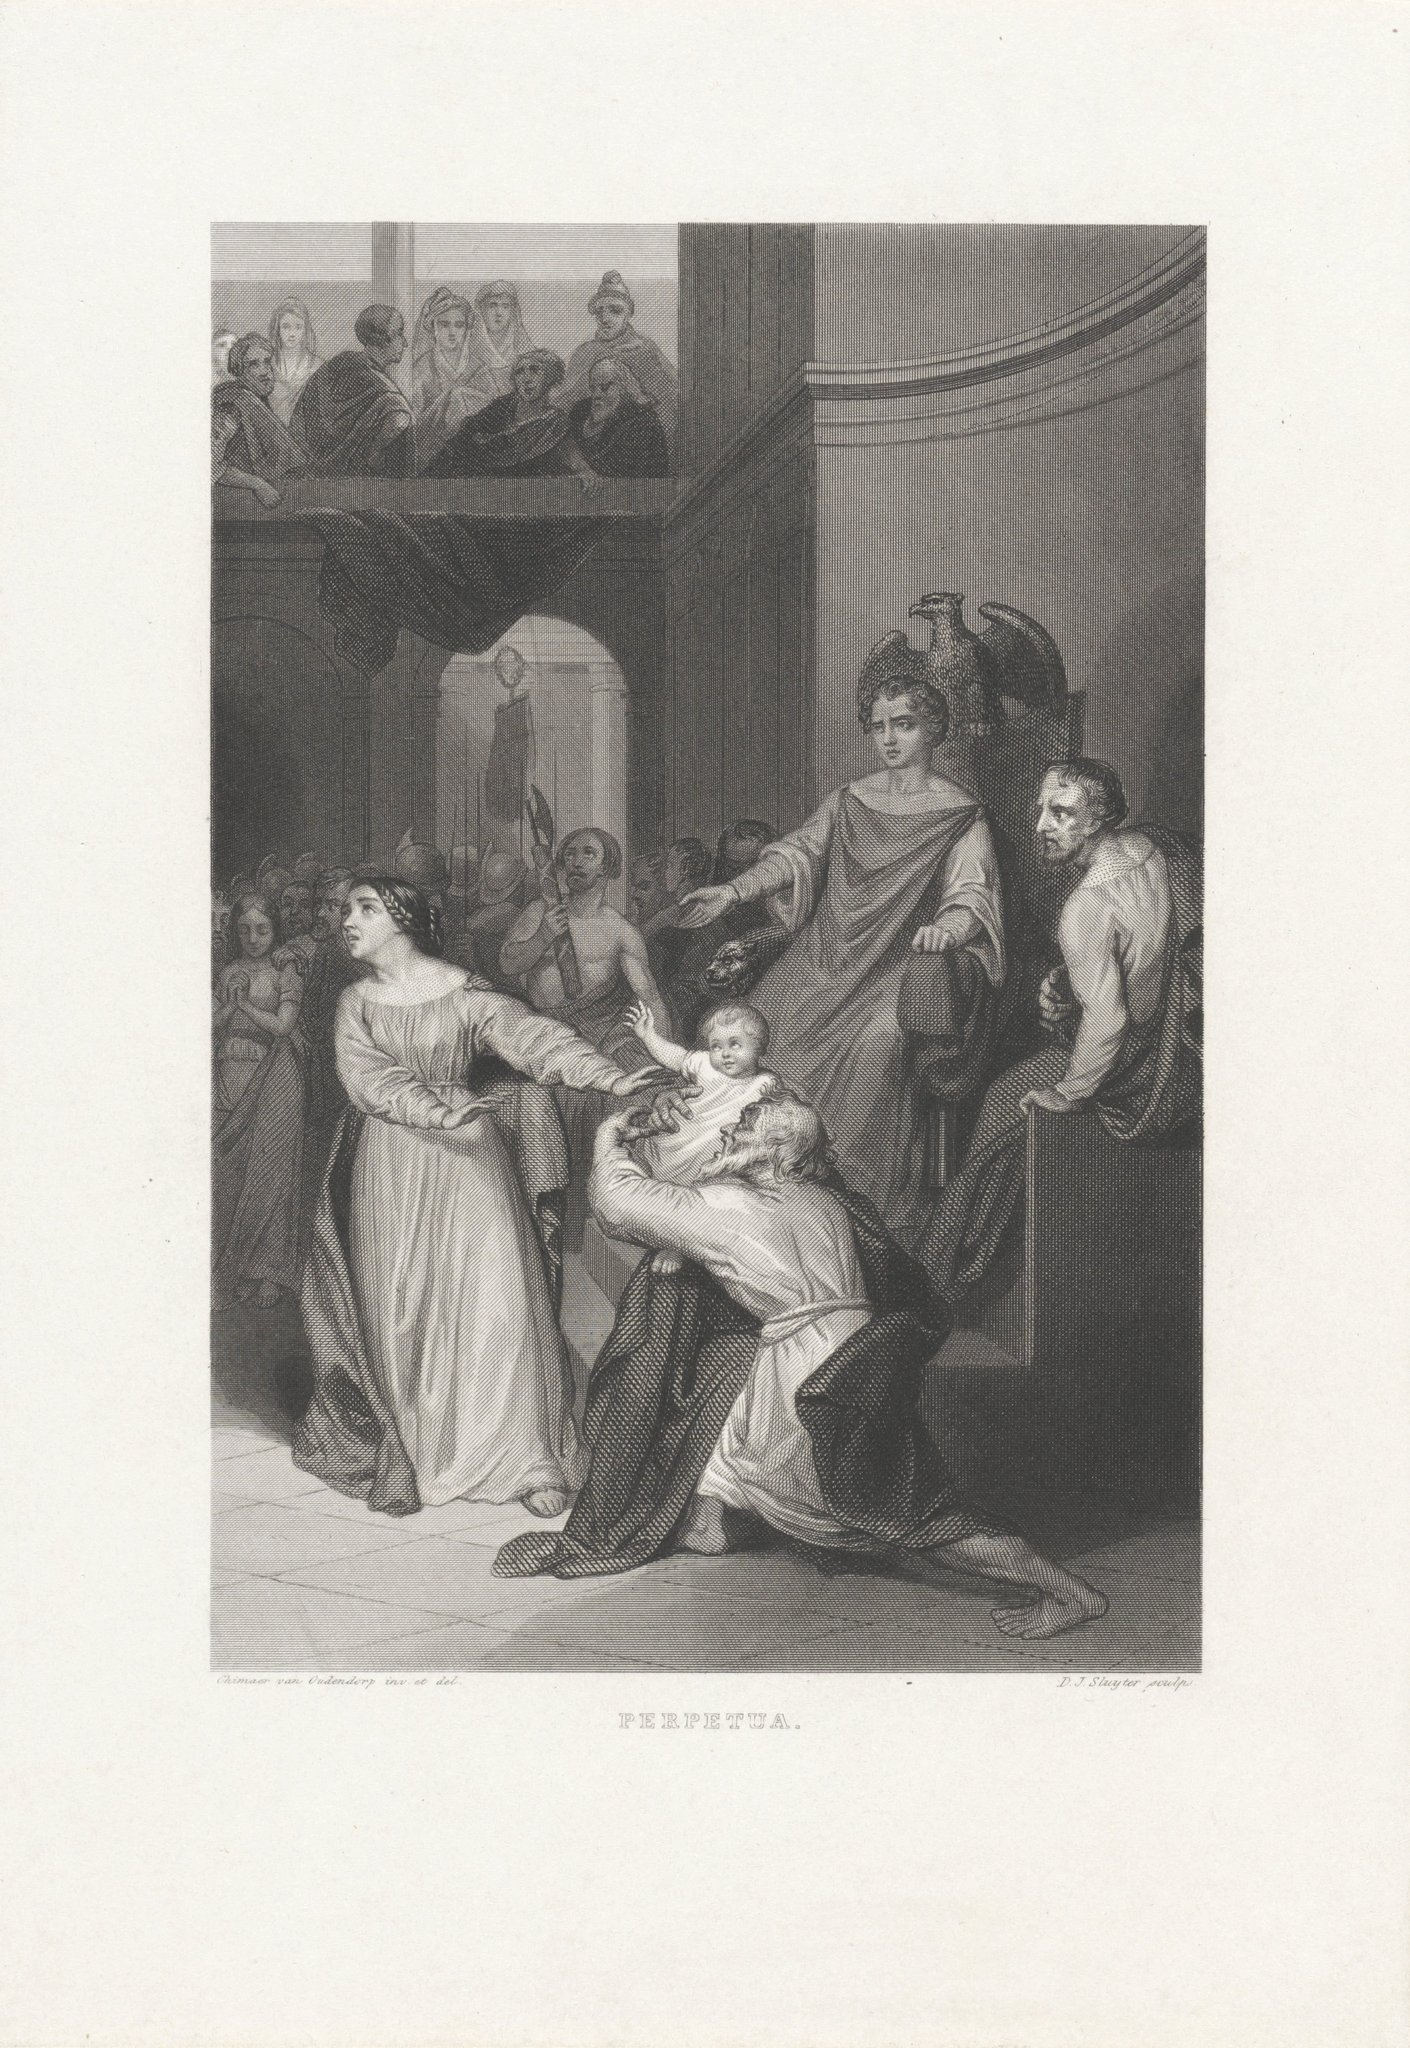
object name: print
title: Perpetua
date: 1826-1886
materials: paper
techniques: engraving, etching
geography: amsterdam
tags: female saints (perpetua) - female saint meditating, in ecstasy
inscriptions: collector's mark: Lugt 2228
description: Perpetua staat in een zaal vol mensen. Zij kijkt omhoog, net als een deel van de omstanders. Achter haar zit een Romeins hoogwaardigheidsbekleder op een troon bekroond met een adelaar. Een oude man stort zich naar voren om Perpetua's baby over te nemen.